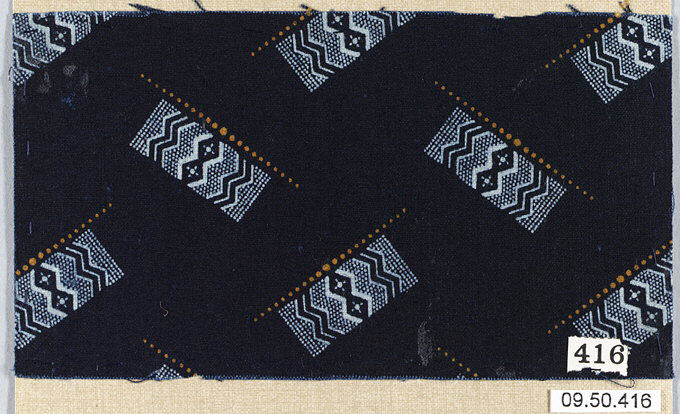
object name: piece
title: Piece (one of 116)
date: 1801-1900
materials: cotton